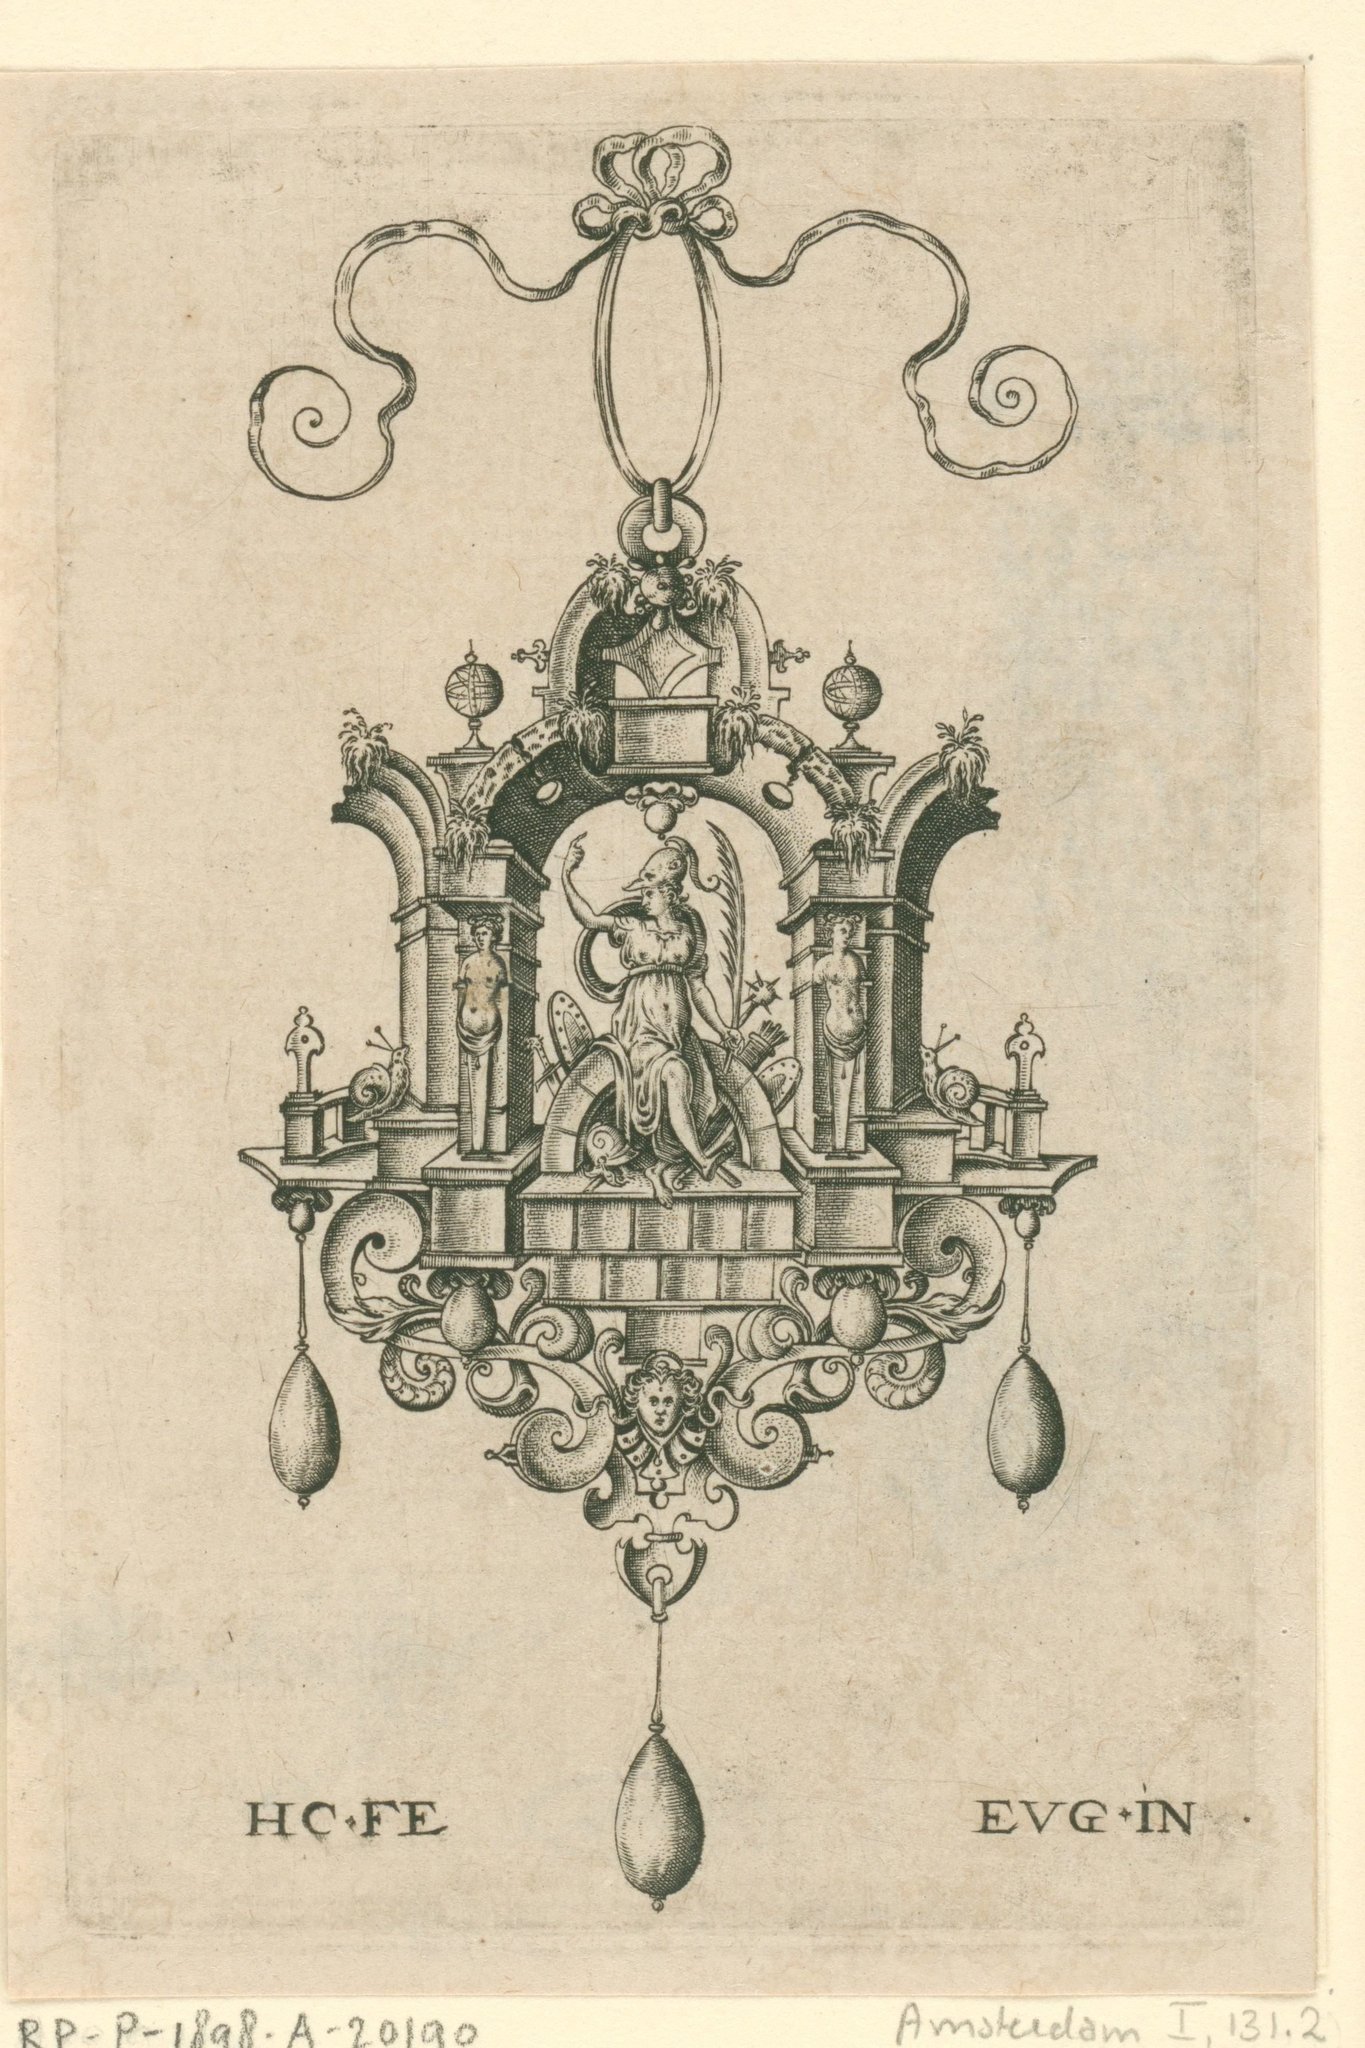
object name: print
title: Pendeloques. Suite van 6 stuks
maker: hieronymus wierix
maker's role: draughtsman, print maker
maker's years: 1553-1619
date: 1563-1619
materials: paper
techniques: engraving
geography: netherlands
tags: pendant, trinket, 'breloque', victory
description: Eén van 9 bladen, uit een serie van 12. Op zes bladen zit in de nis een figuur. Aan elke hanger hangen drie parels.